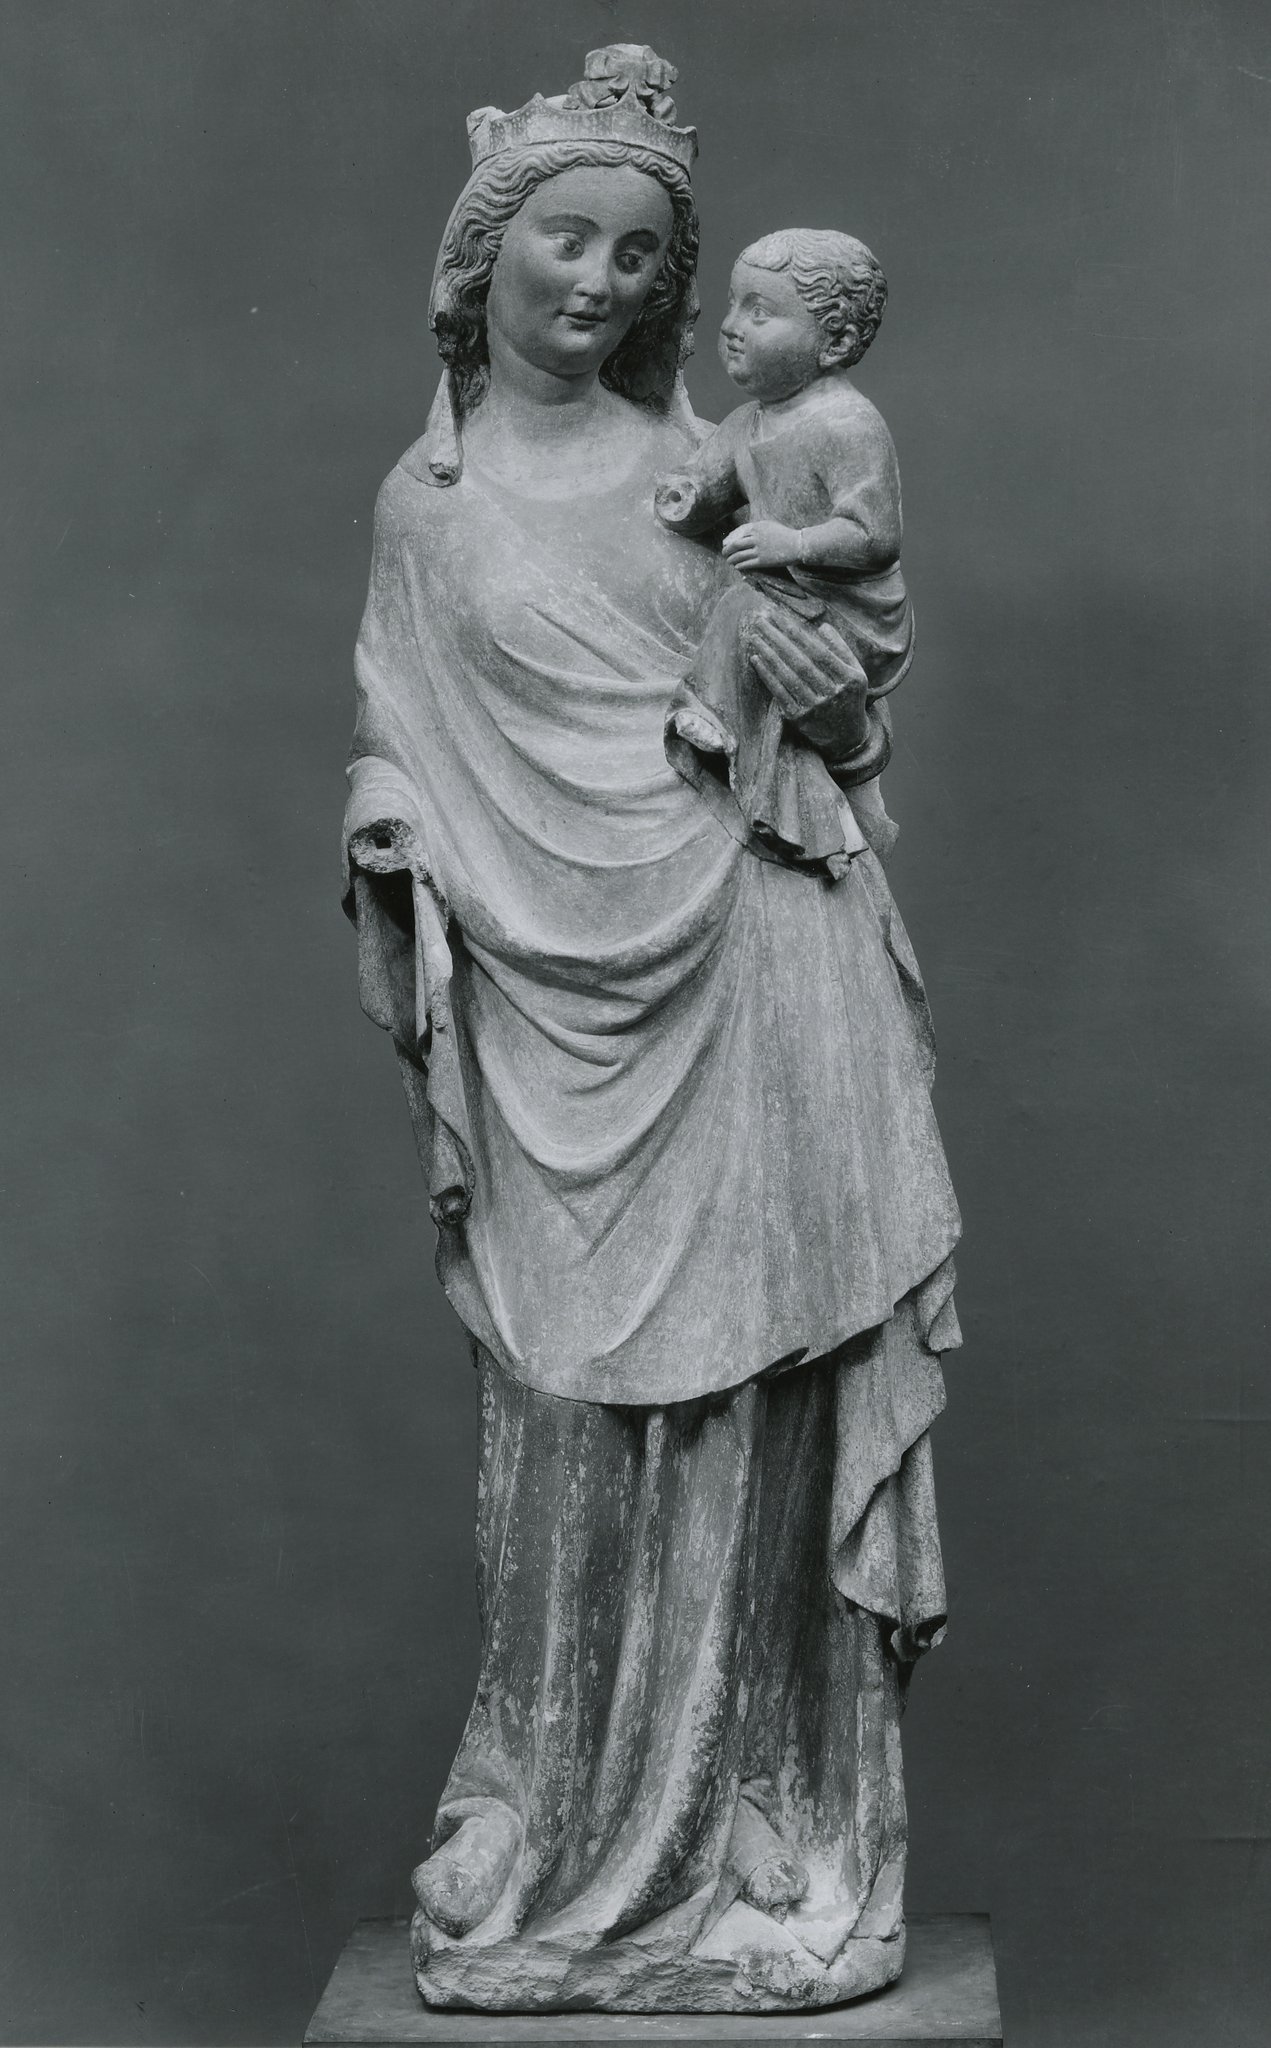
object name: statue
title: Standing Virgin and Child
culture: french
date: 1300-1350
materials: paint, stone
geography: france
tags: madonna and child